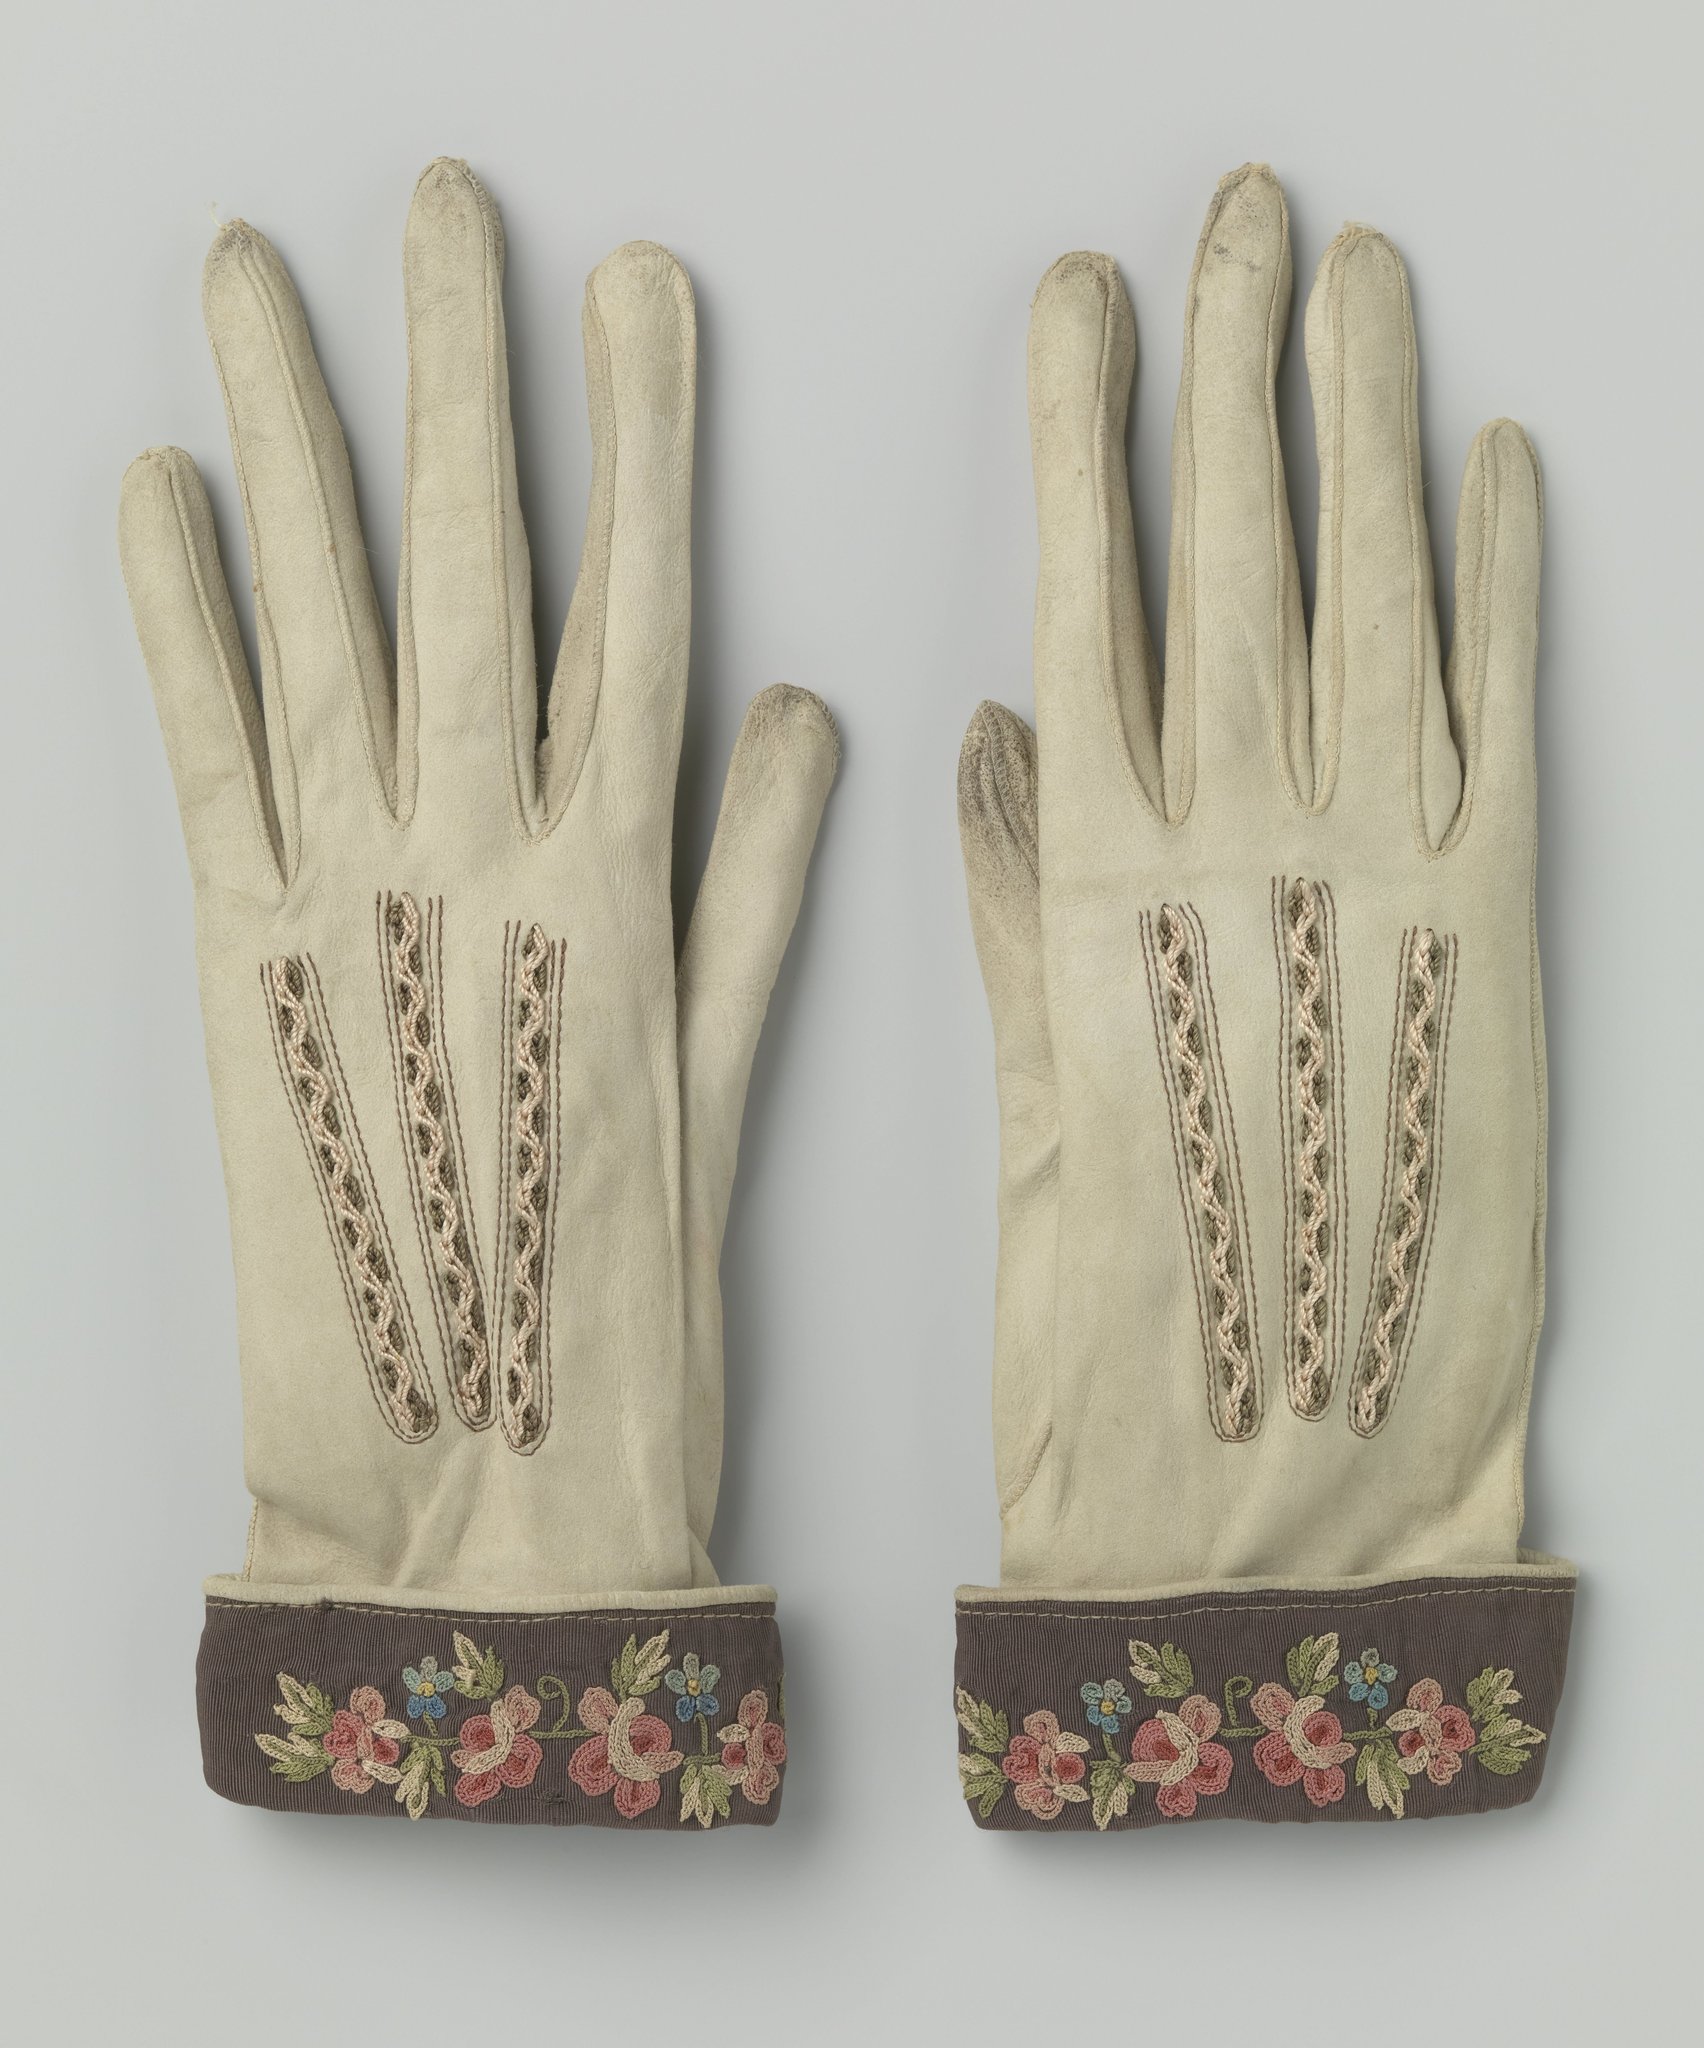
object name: womenswear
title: Handschoenen van zeemleer, met smalle teruggeslagen kappen van leverkleurige ripszijde gebrocheerd met bloemen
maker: vallet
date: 1890-1910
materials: leather, silk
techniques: brocade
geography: paris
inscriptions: stamp: ‘tekst’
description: Rechter handschoenen van zeemleer, met leverkleurige zijden (?) smalle teruggeslagen kappen. Sluit een de binnenkant met een drukknop. Op de hand drie geborduurde lijnen bestaande uit slingers in rose en groen. Hieromheen een dunne garnering van bruine stiksteekjes. Op de kappen vier roze/rode roosjes met blaadjes. Adres (in de linkerhandschoen een stempel): Made in France, (in de linkerhandschoen de stempels): VALLET PARIS / Made in France / 6.